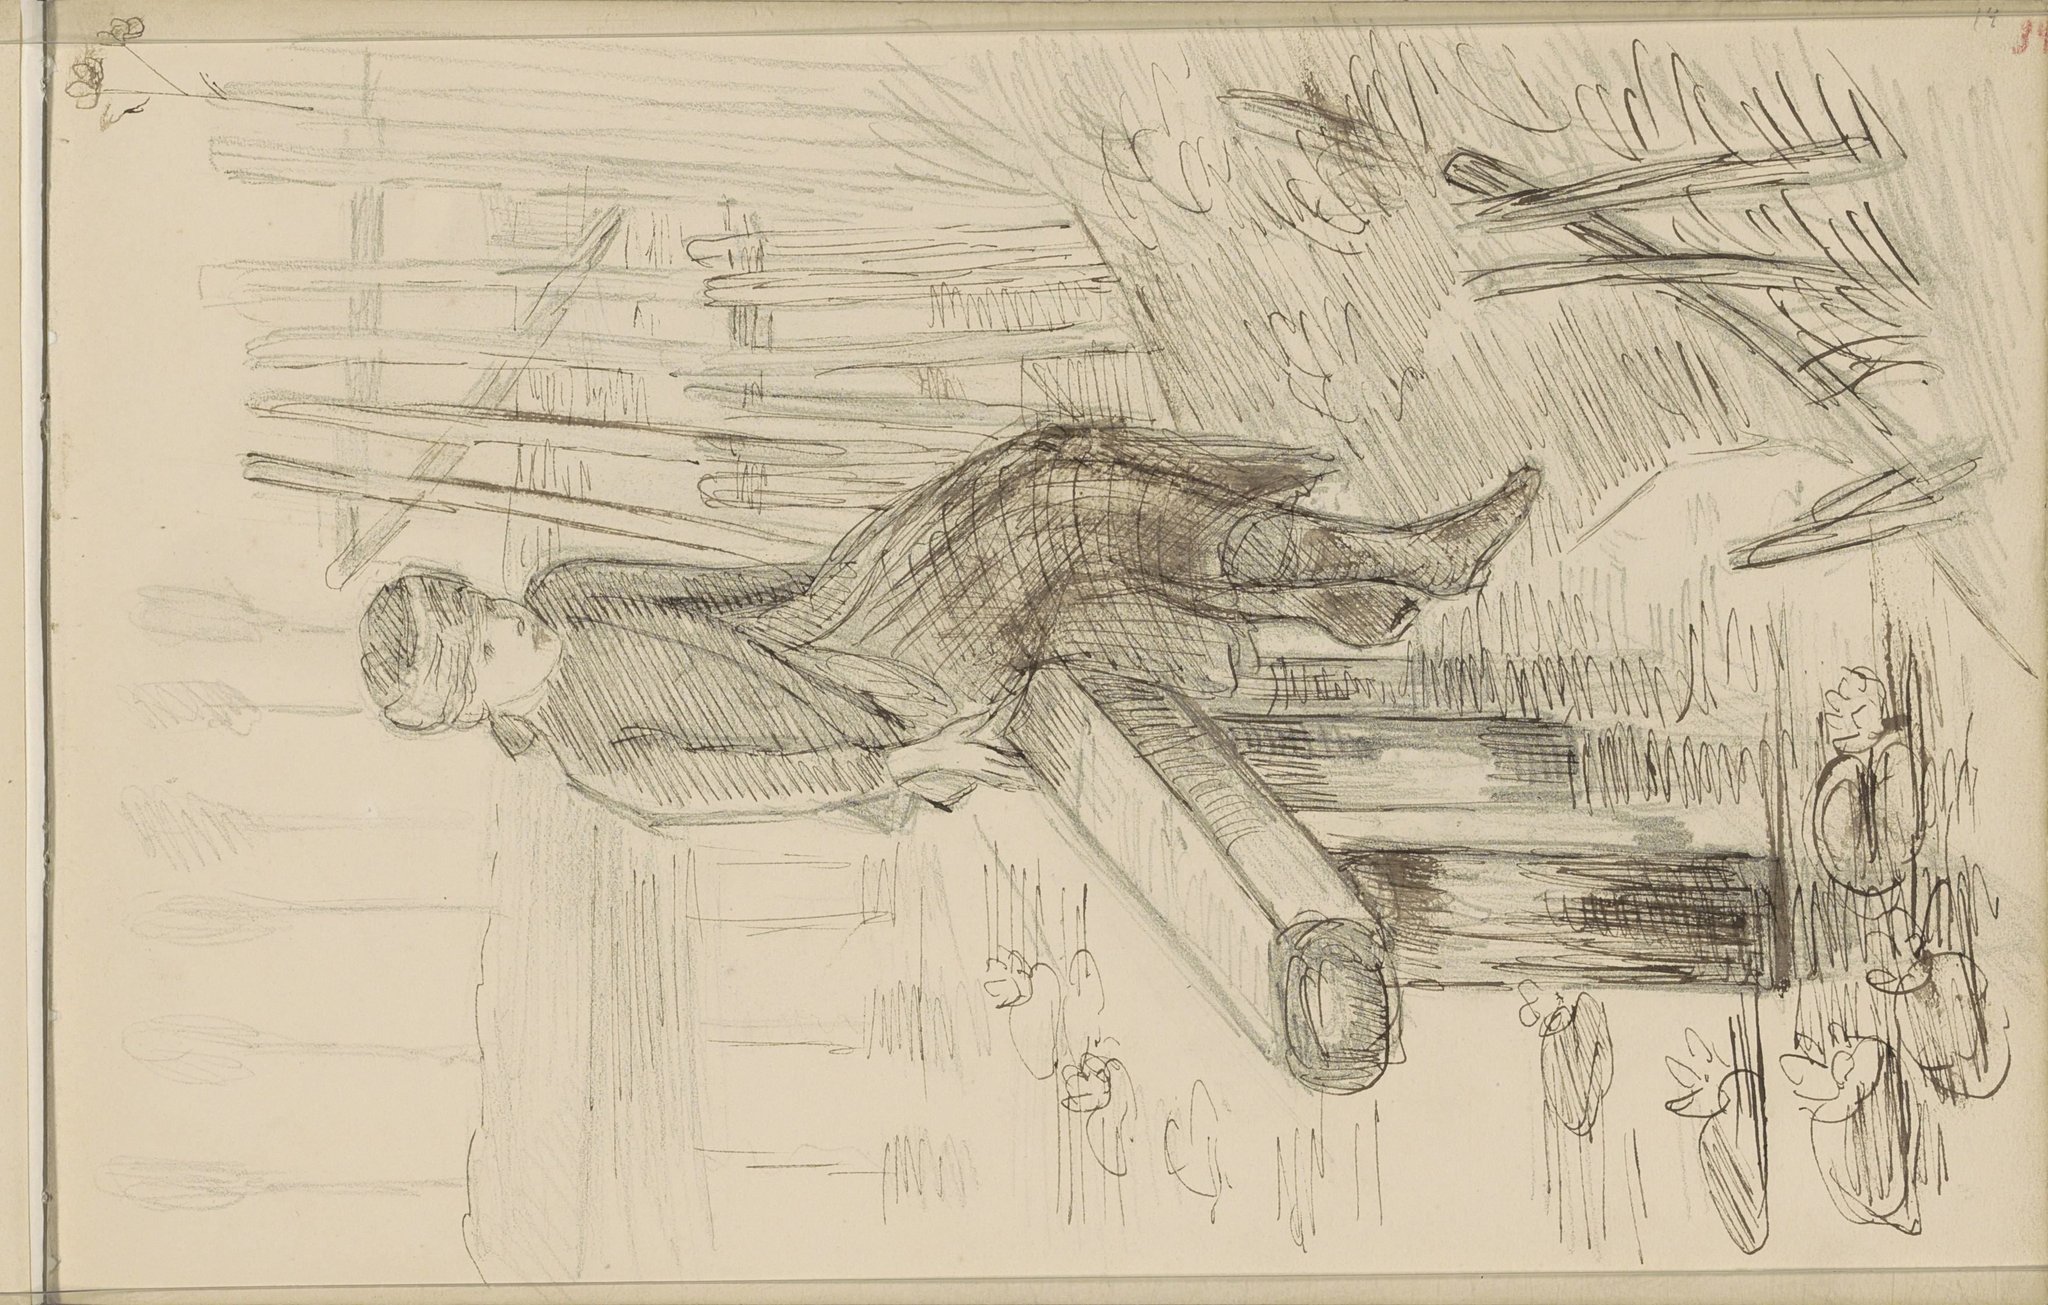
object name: sketchbook leaf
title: Jongen zittend op een balk op palen aan een waterkant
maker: jozef israëls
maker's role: draughtsman, painter, print maker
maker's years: 1824-1911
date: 1834-1911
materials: ink, paper, pencil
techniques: pen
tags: sitting on an elevation (+ young male (human being)), landscapes with waters, waterscapes, seascapes (in the temperate zone)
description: In het water liggen waterlelies. Op de achtergrond een rij bomen. Blad 14 recto uit een schetsboek met 25 bladen.